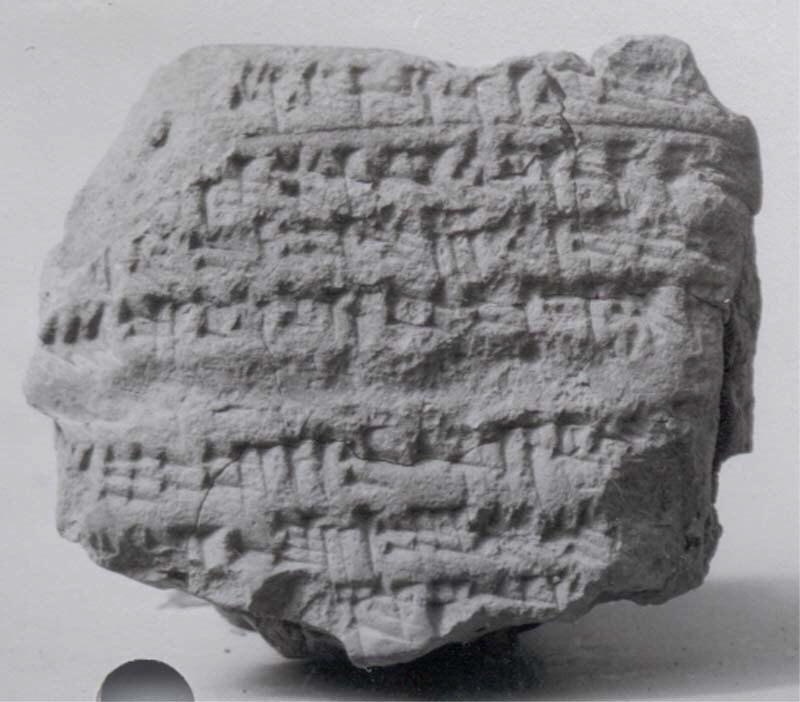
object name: cuneiform tablet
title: Cuneiform tablet: account of flour, Ebabbar archive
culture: babylonian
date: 549 BCE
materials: clay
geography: mesopotamia